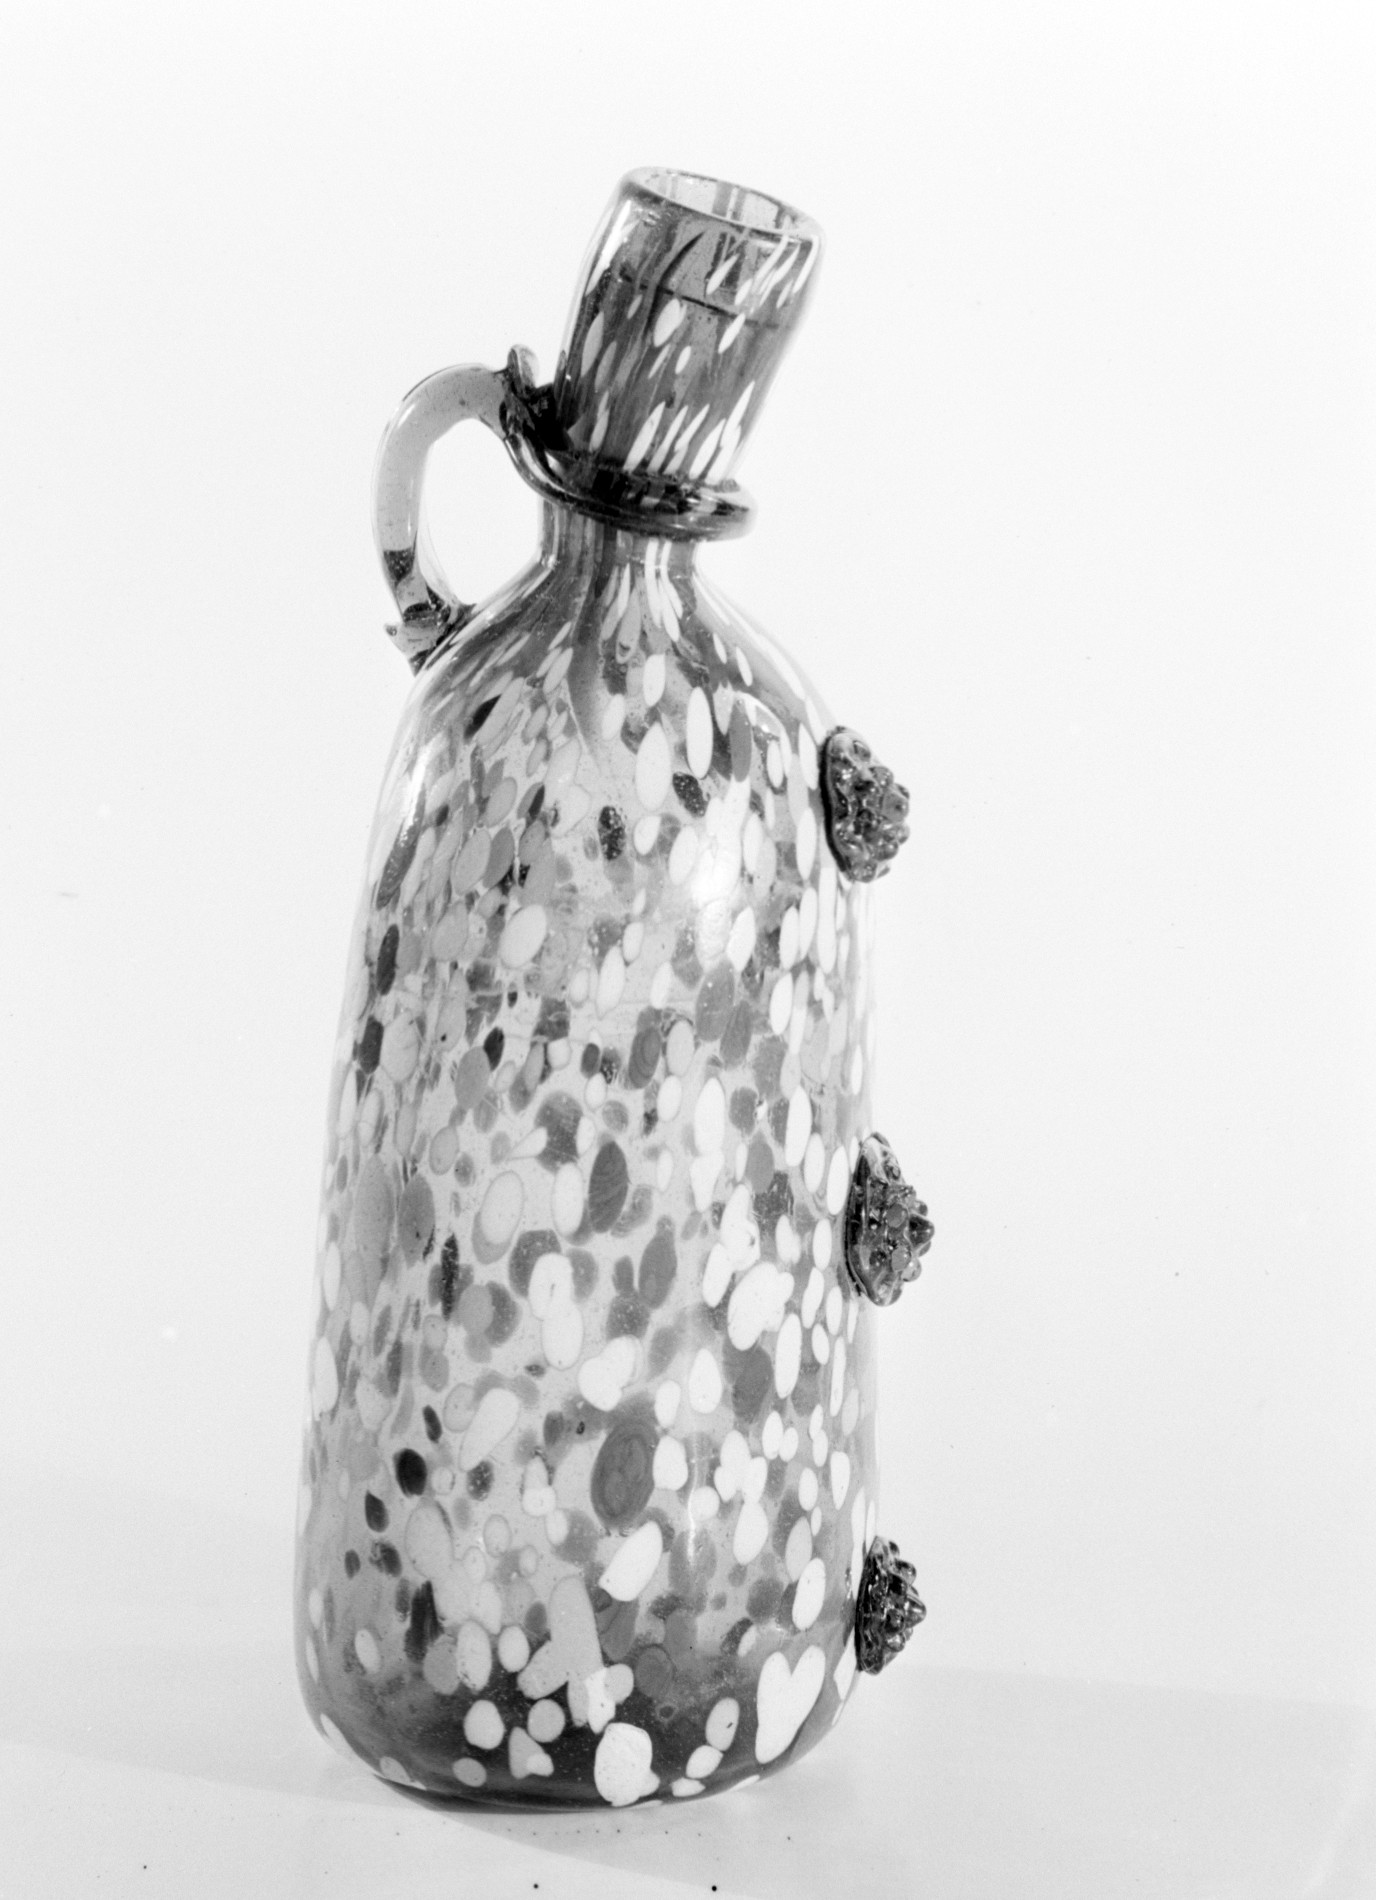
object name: feeding bottle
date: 1601-1700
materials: glass